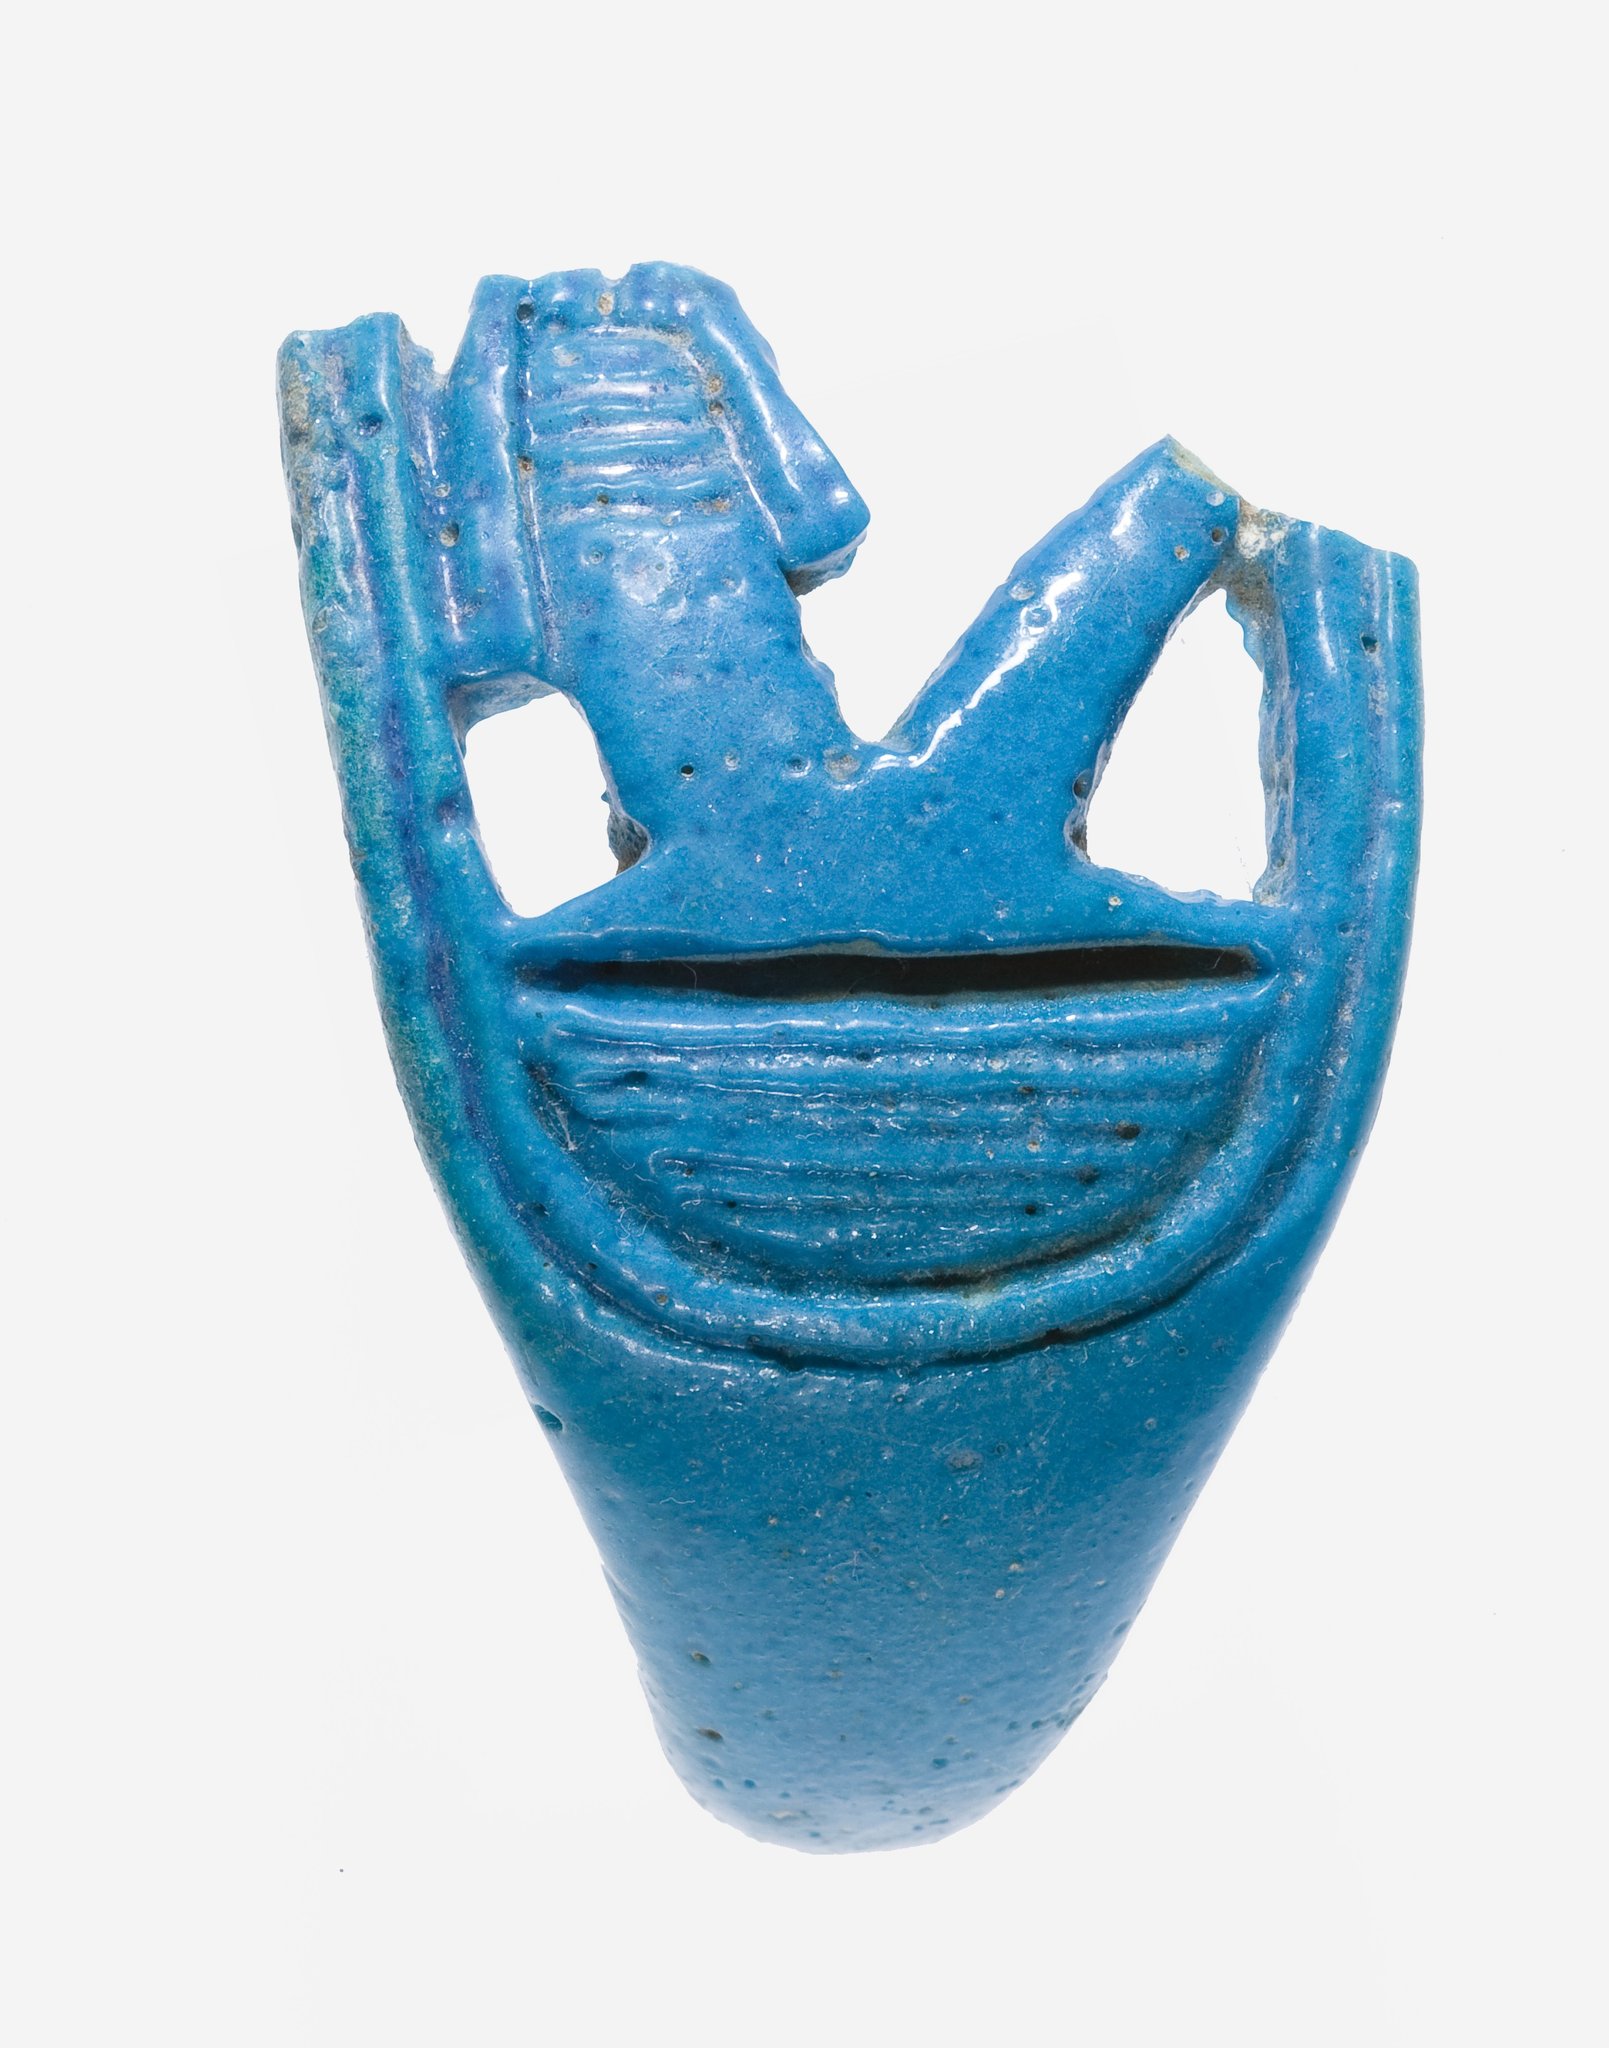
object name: bracelet, amenhotep iii, nebmaatre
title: Bracelet Fragment with the Throne Name of Amenhotep III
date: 1390-1352 BCE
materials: faience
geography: egypt